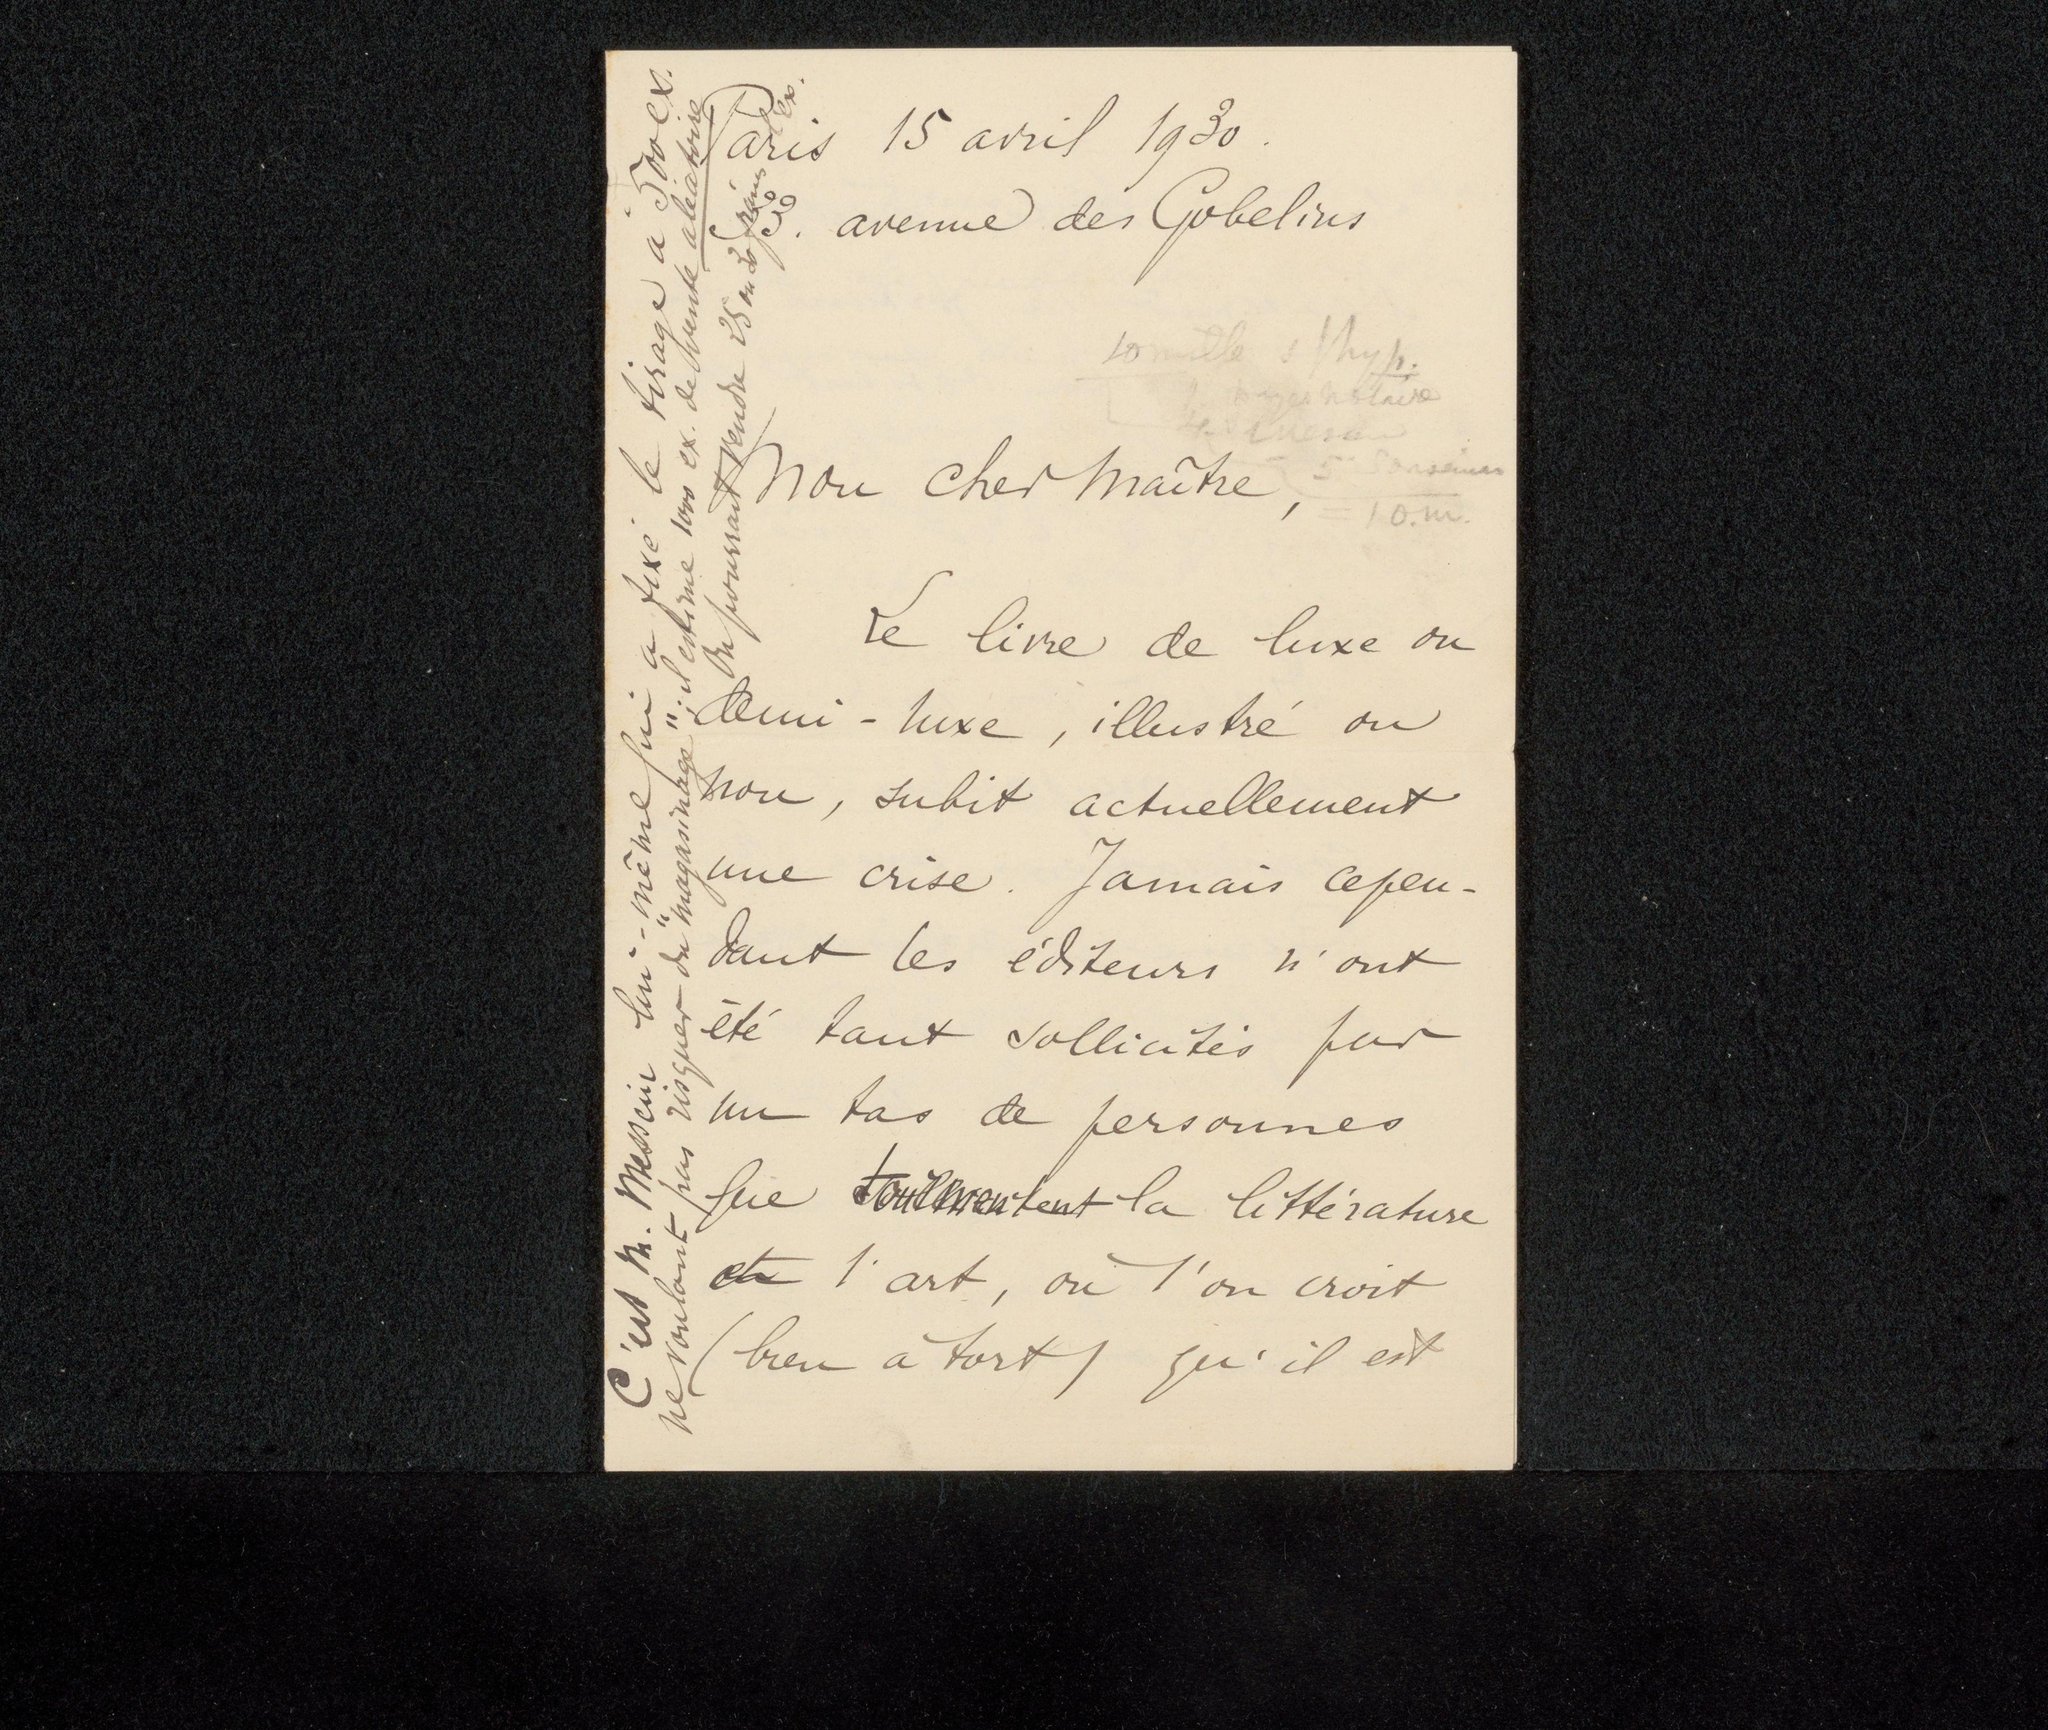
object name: letter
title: Brief aan Philip Zilcken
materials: ink, paper, pencil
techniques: pen, printing, writing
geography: paris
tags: publisher, albert messein, léon bocquet, paul verlaine, maria biermé, the hague, painter, draughtsman, philip zilcken, diseases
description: Brief en envelop bevatten aantekeningen van Philip Zilcken. Bijgesloten is een brief van Albert Messein aan Léon Bouquet.